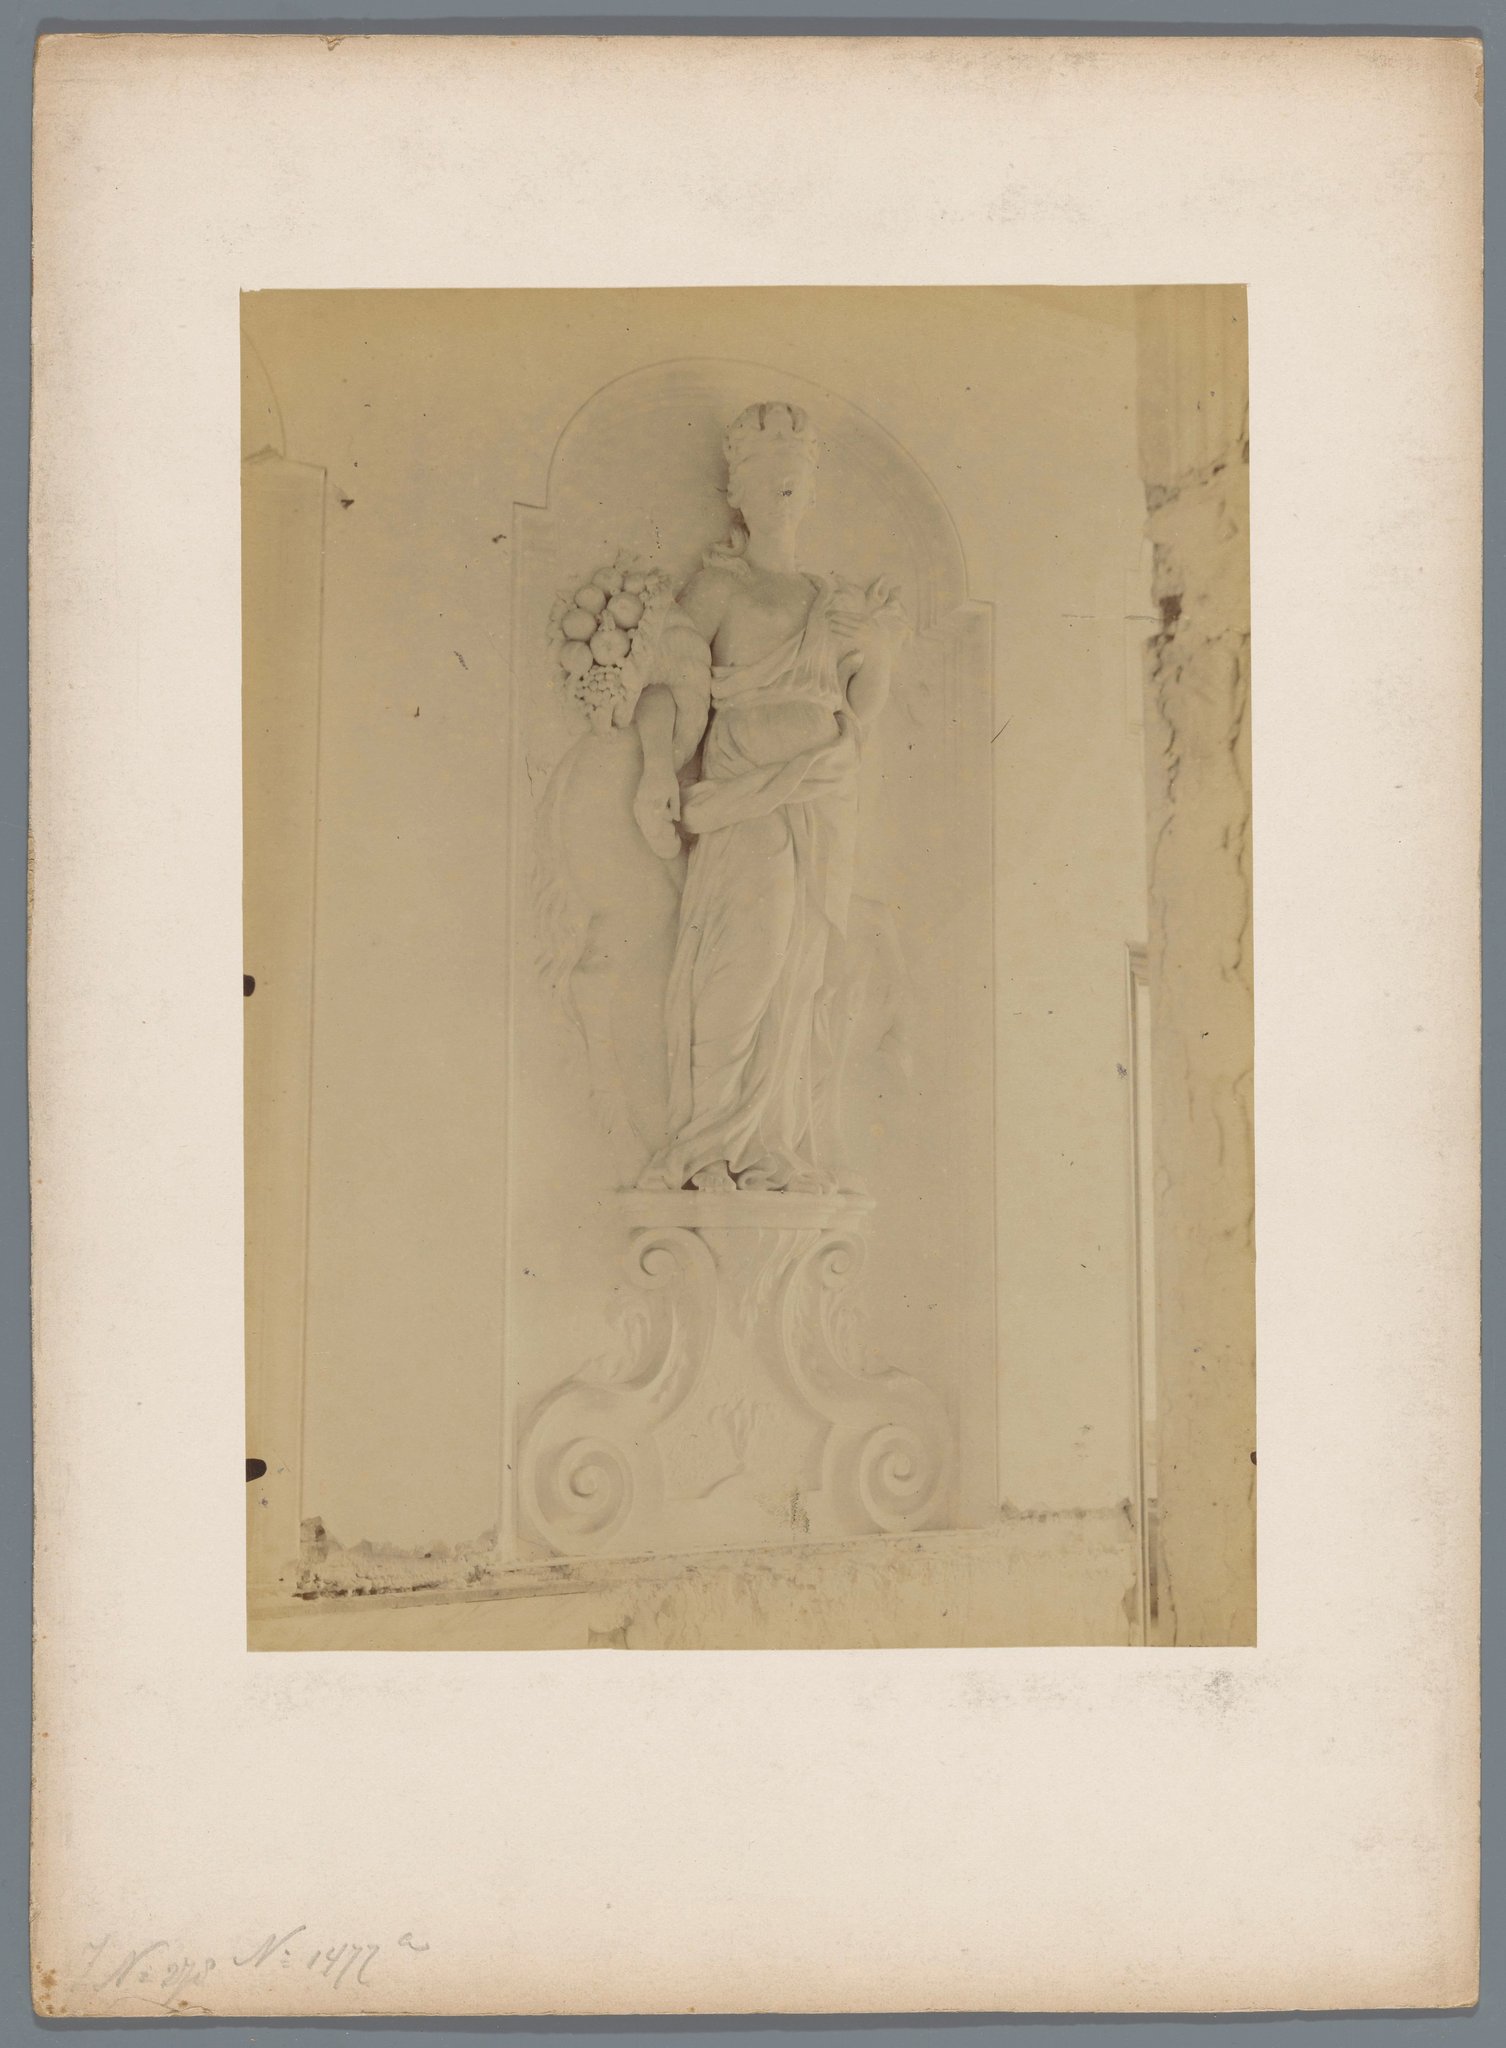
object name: photograph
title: Stuccobeeld in Huis ter Meer te Maarssen, voorstellende het continent Europa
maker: Anonymous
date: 1875-1900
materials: cardboard, photographic support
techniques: albumen print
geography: huis ter meer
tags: 'cornucopia', horn of plenty, sculpture, horse, interior ~ representation of a building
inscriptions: inscription: ‘Maarsen, U. Huis ,,ter Meer''. gesloopt Aug. 1903. Een der stuccobeelden in den gang.’, inscription: ‘neg. no 15960 foto 22306’, annotation